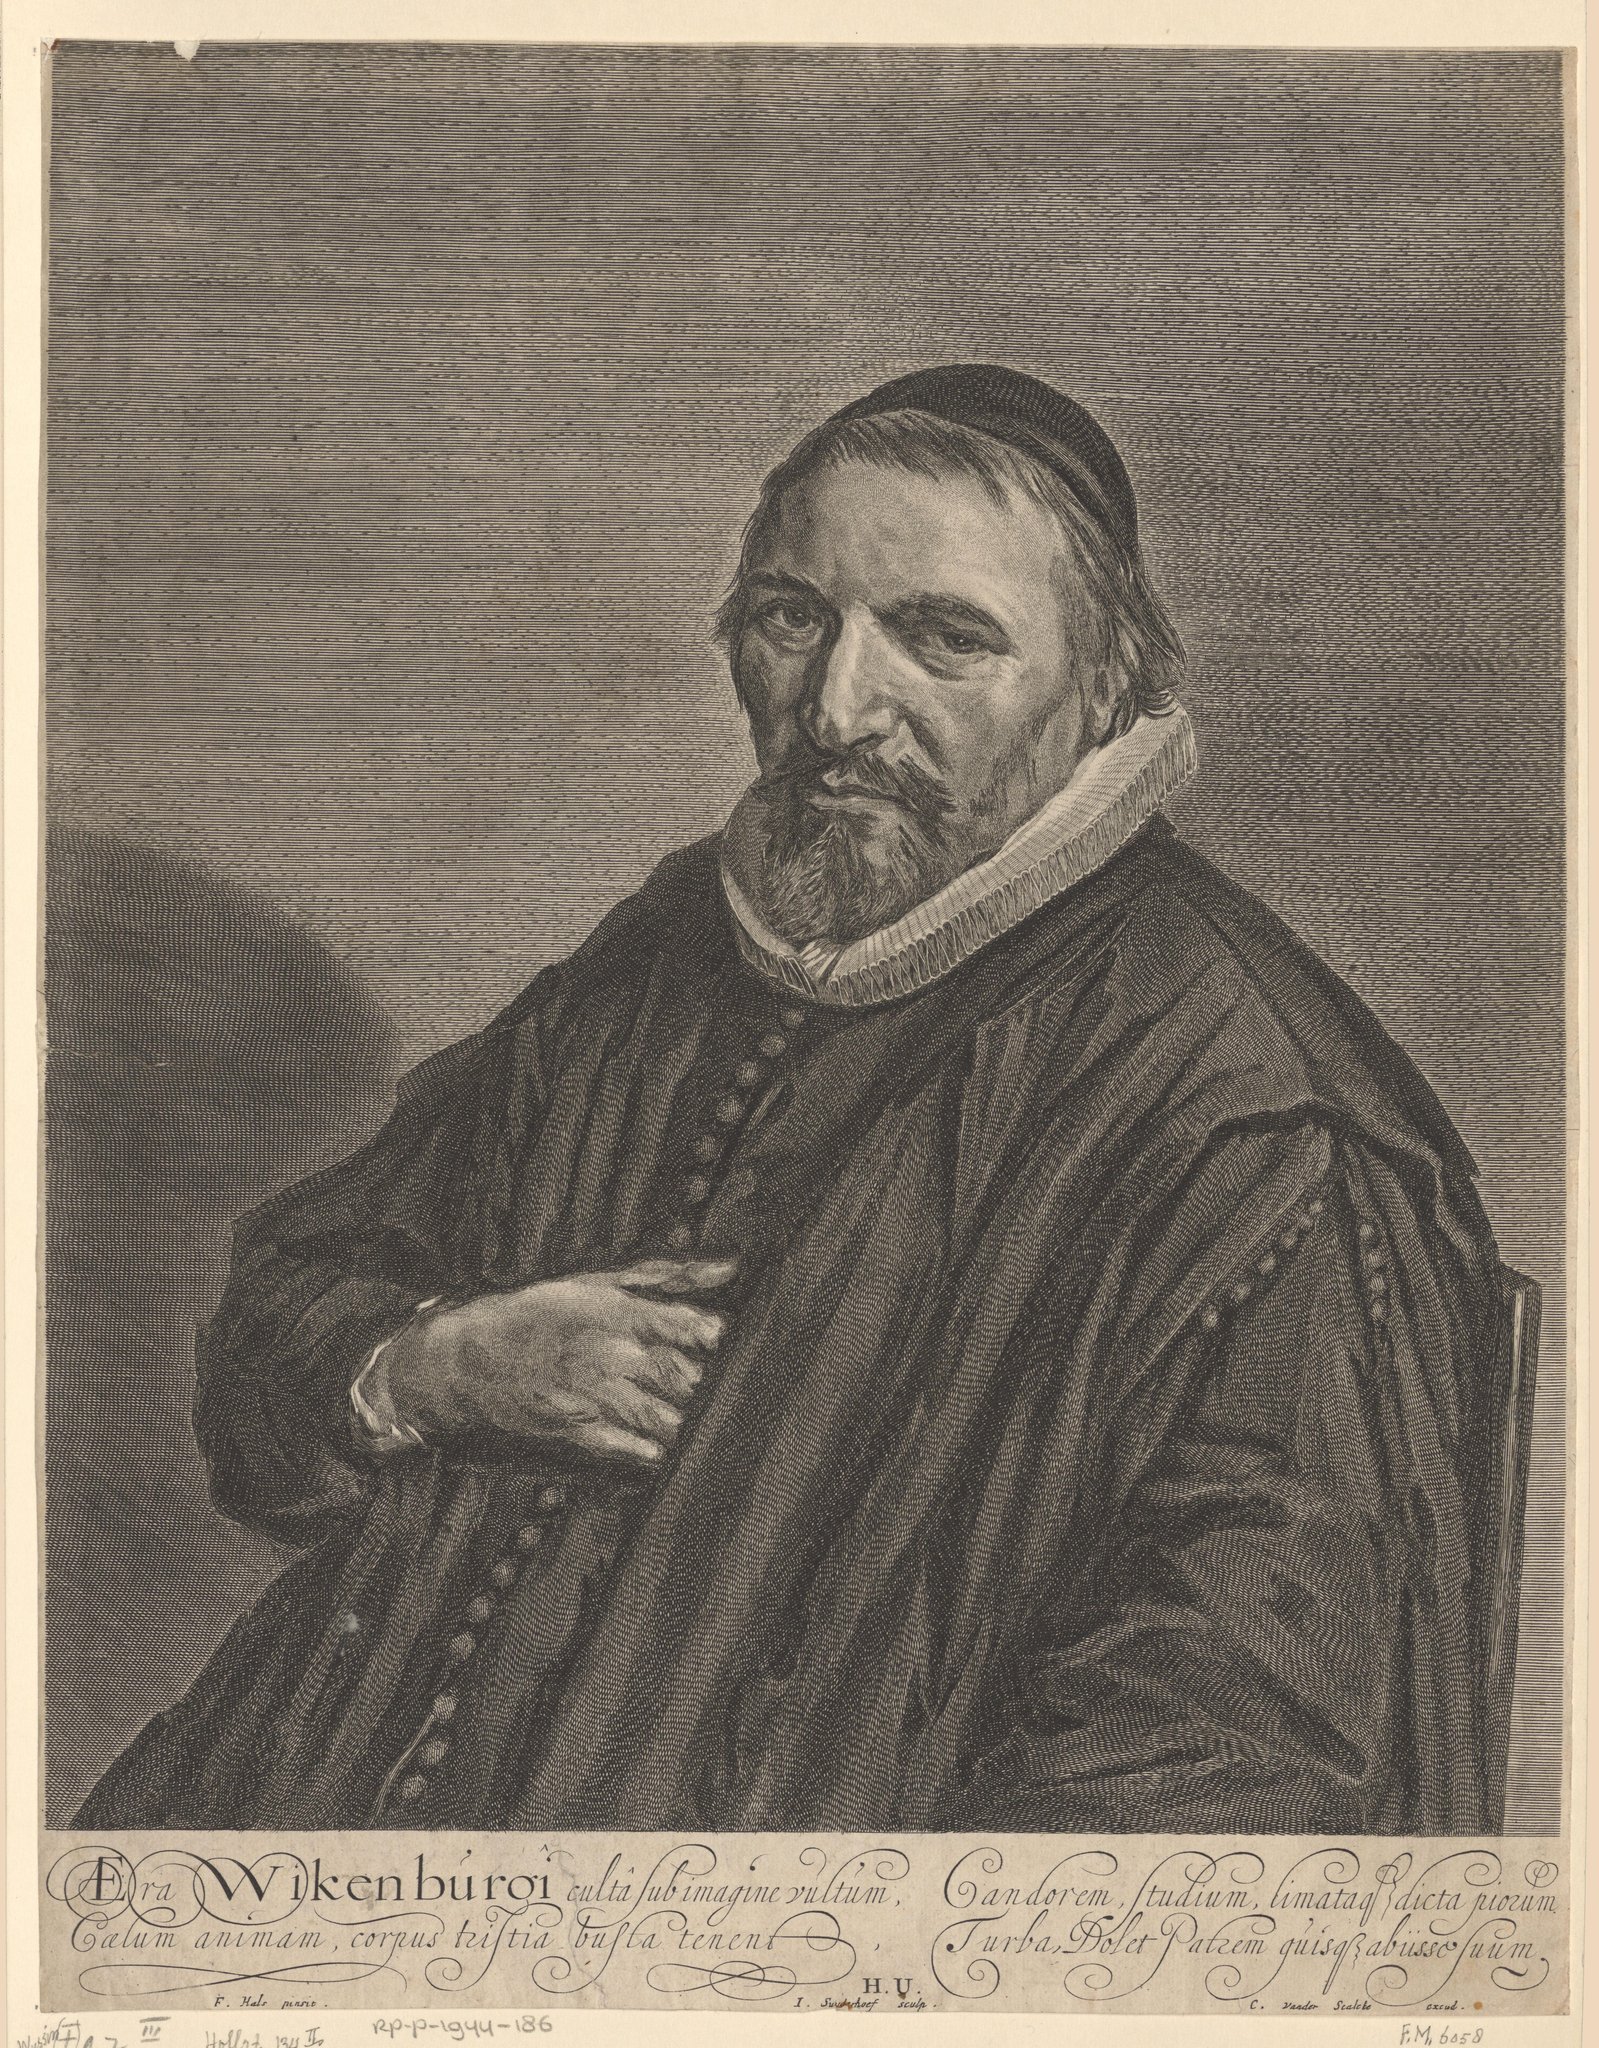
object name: print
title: Portret van Theodorus Wikenburg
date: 1623-1686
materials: paper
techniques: engraving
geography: netherlands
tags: historical persons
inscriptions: collector's mark: Lugt 2228